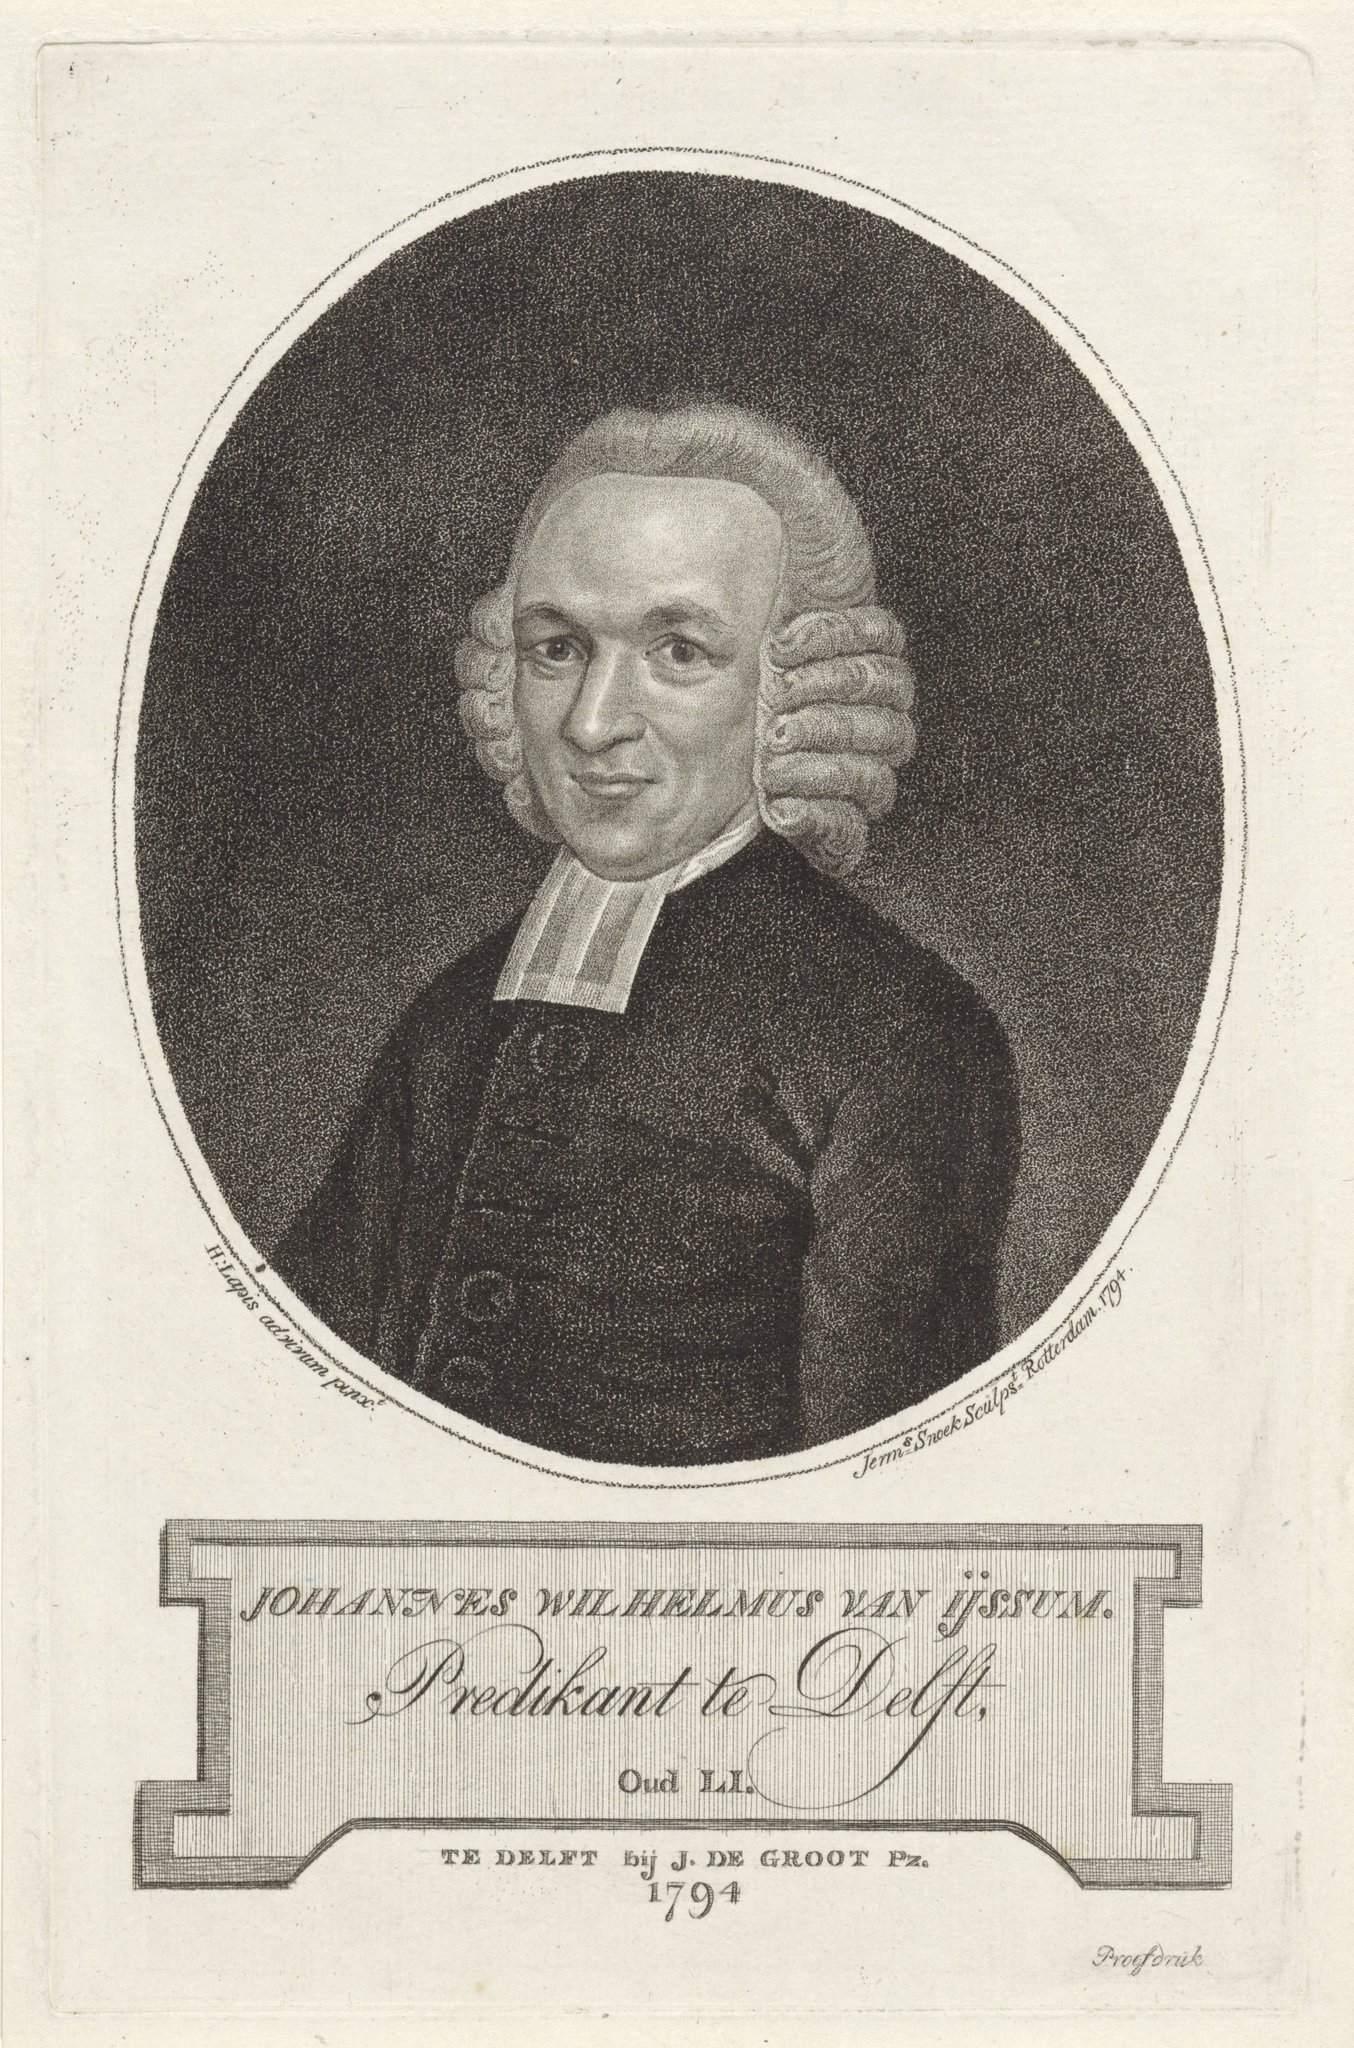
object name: print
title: Portret van Johannes Wilhelmus van IJssum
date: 1794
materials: paper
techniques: etching, engraving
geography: rotterdam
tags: johannes wilhelmus van ijssum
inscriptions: collector's mark: Lugt 2228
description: Portret van Johannes Wilhelmus van IJssum, predikant te Delft, op 51-jarige leeftijd. Onder het portret staan in een cartouche zijn naam, leeftijd en functie.